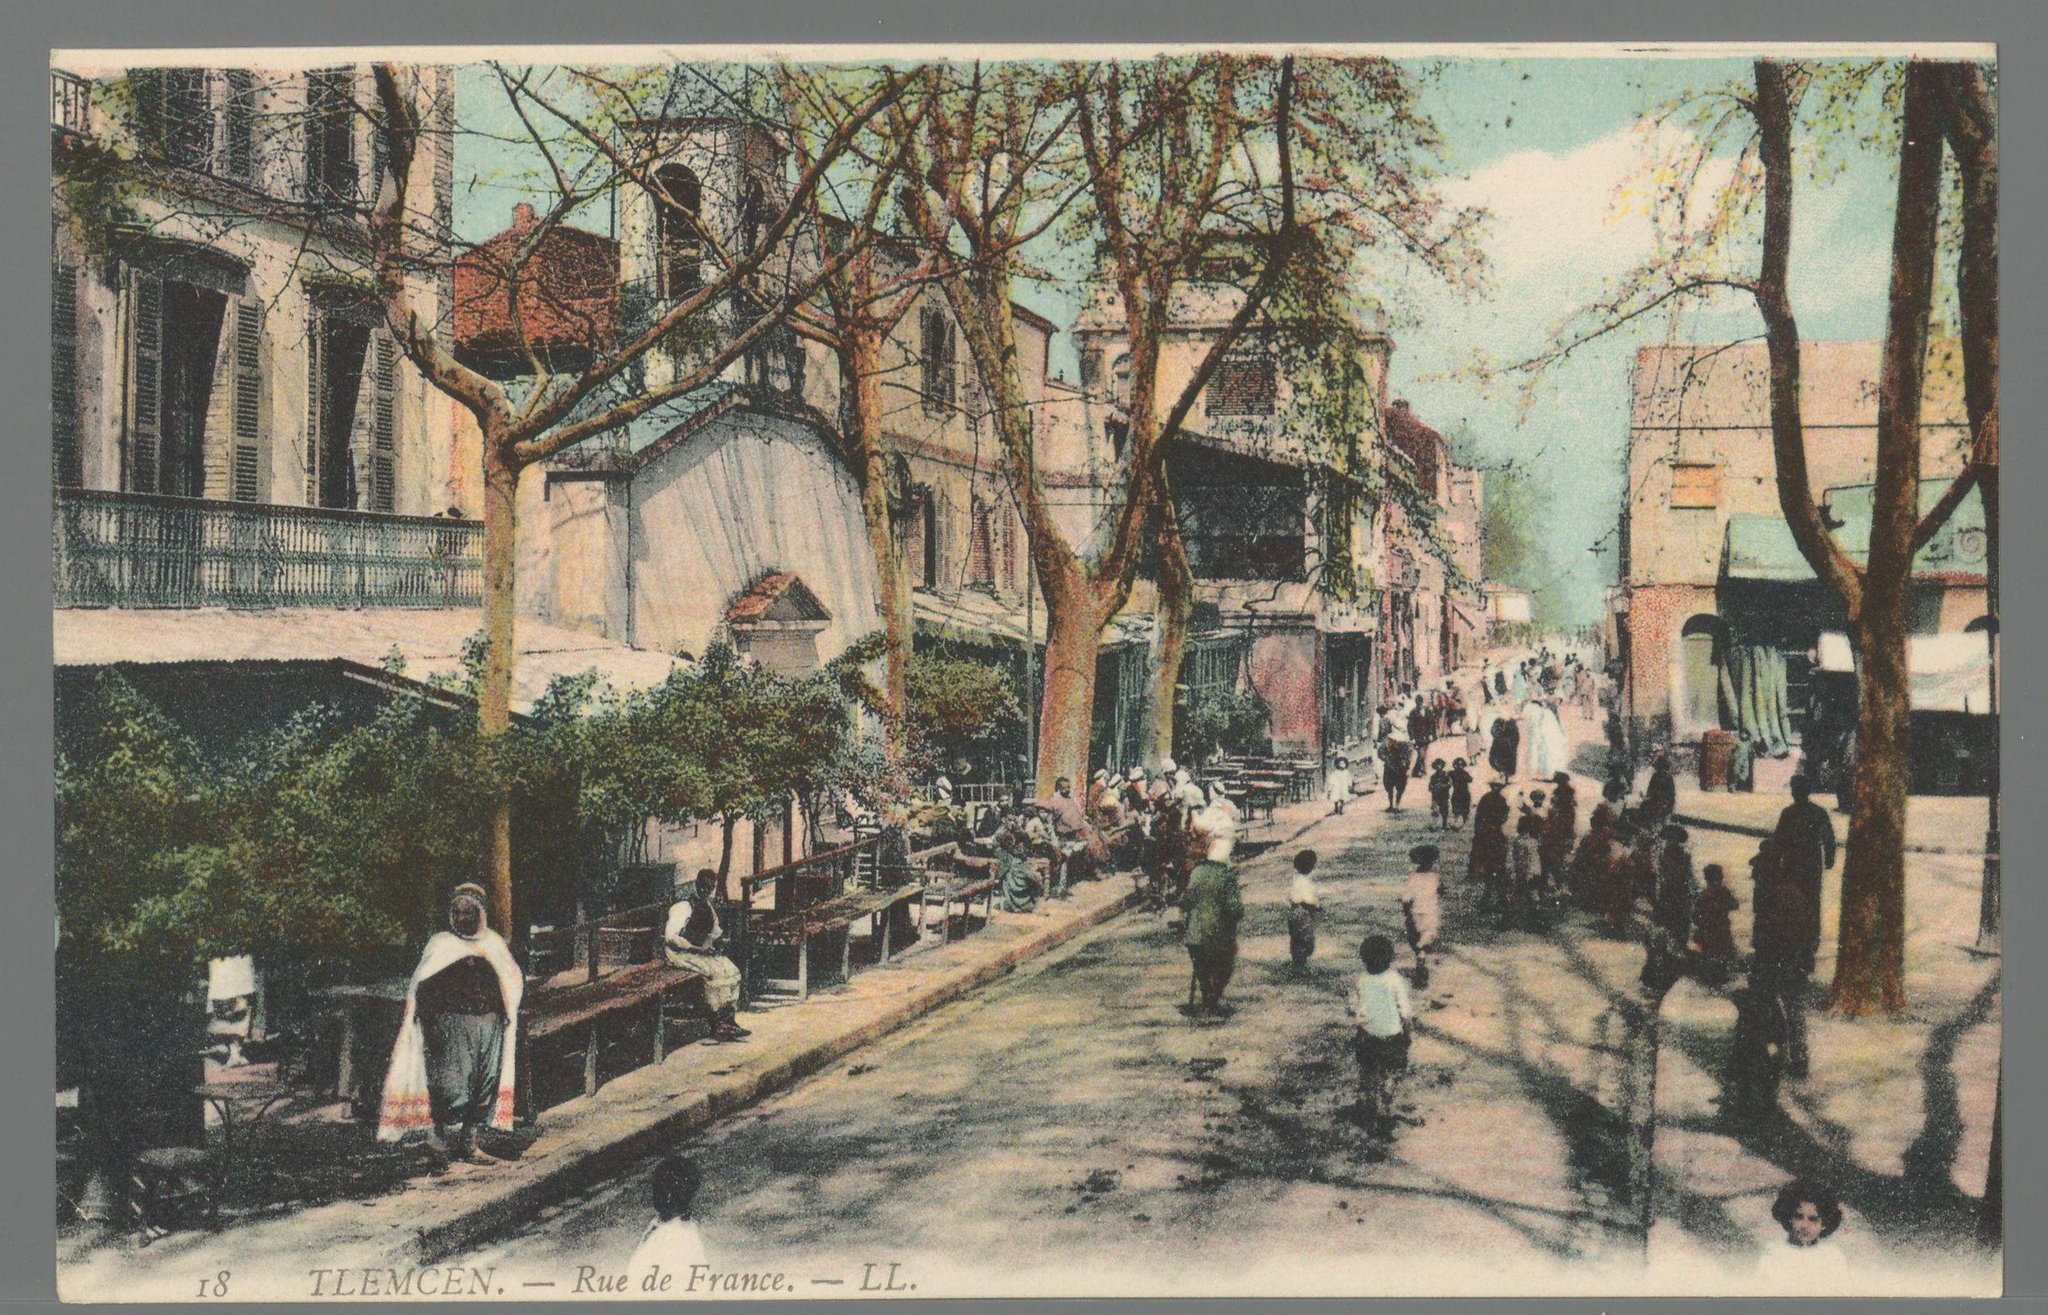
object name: photomechanical print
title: Tlemcen. Rue de France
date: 1903-1905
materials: cardboard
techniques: photograph, lithograph, writing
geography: tlemcen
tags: street (+ city(-scape) with figures, staffage)